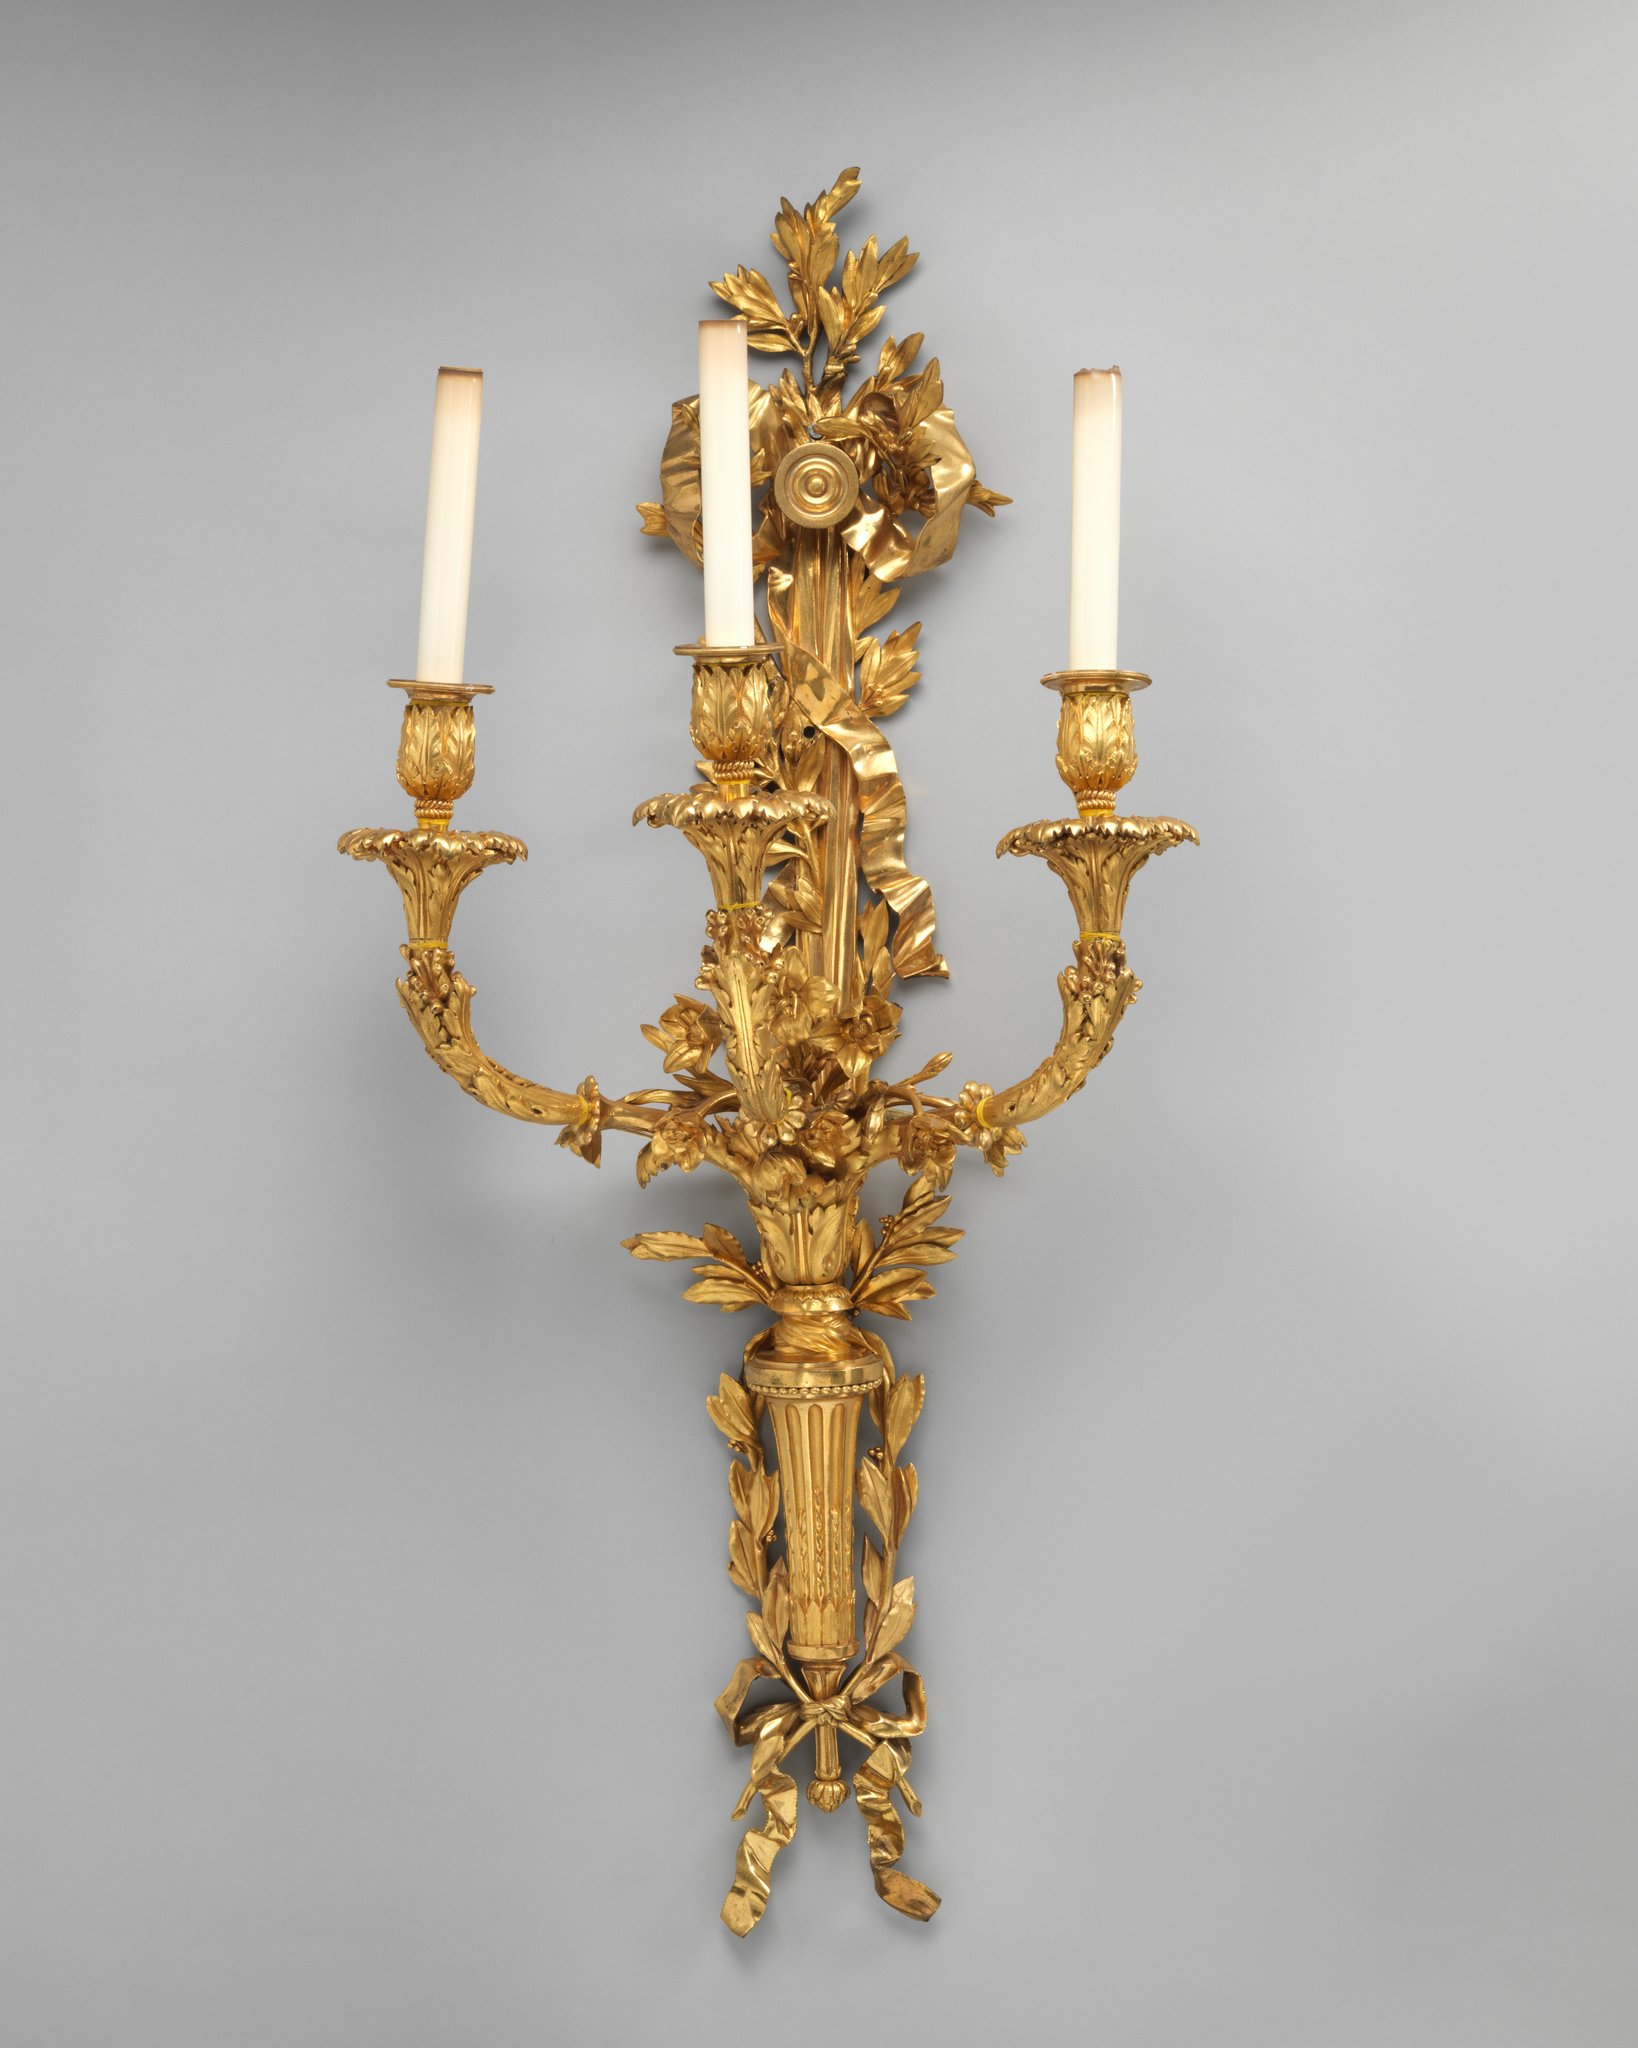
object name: wall light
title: Three-branch wall light (one of a pair) (bras de lumière)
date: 1785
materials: gilt bronze